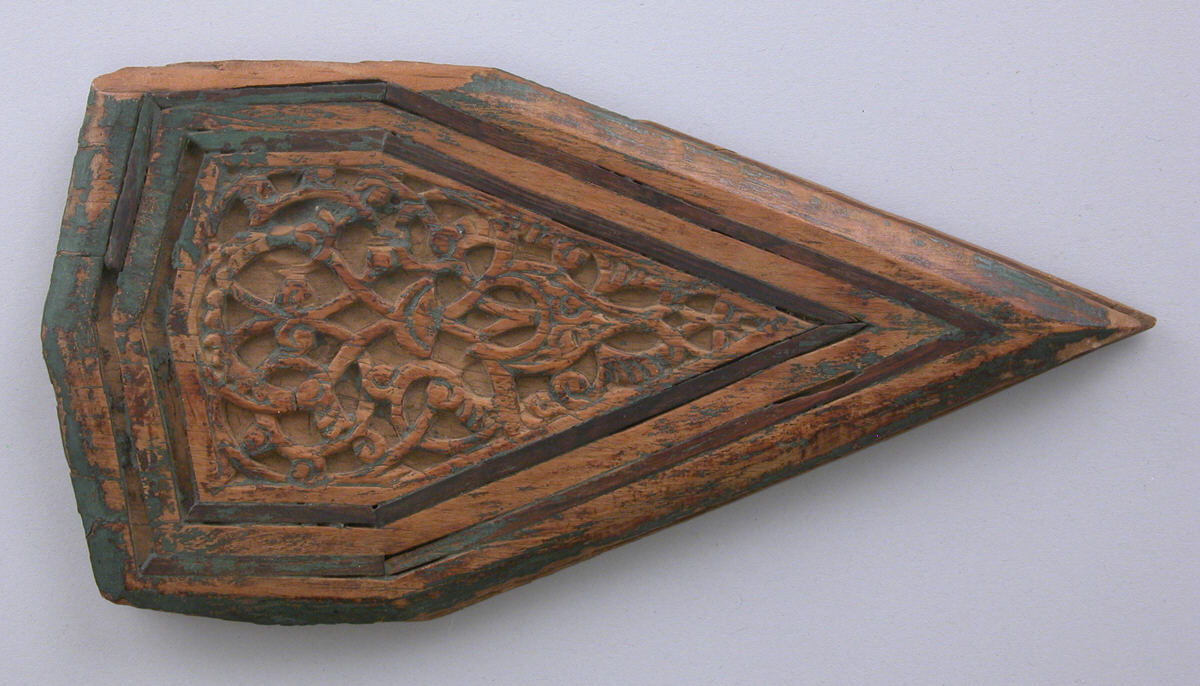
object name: panel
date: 1201-1400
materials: wood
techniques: carving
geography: egypt